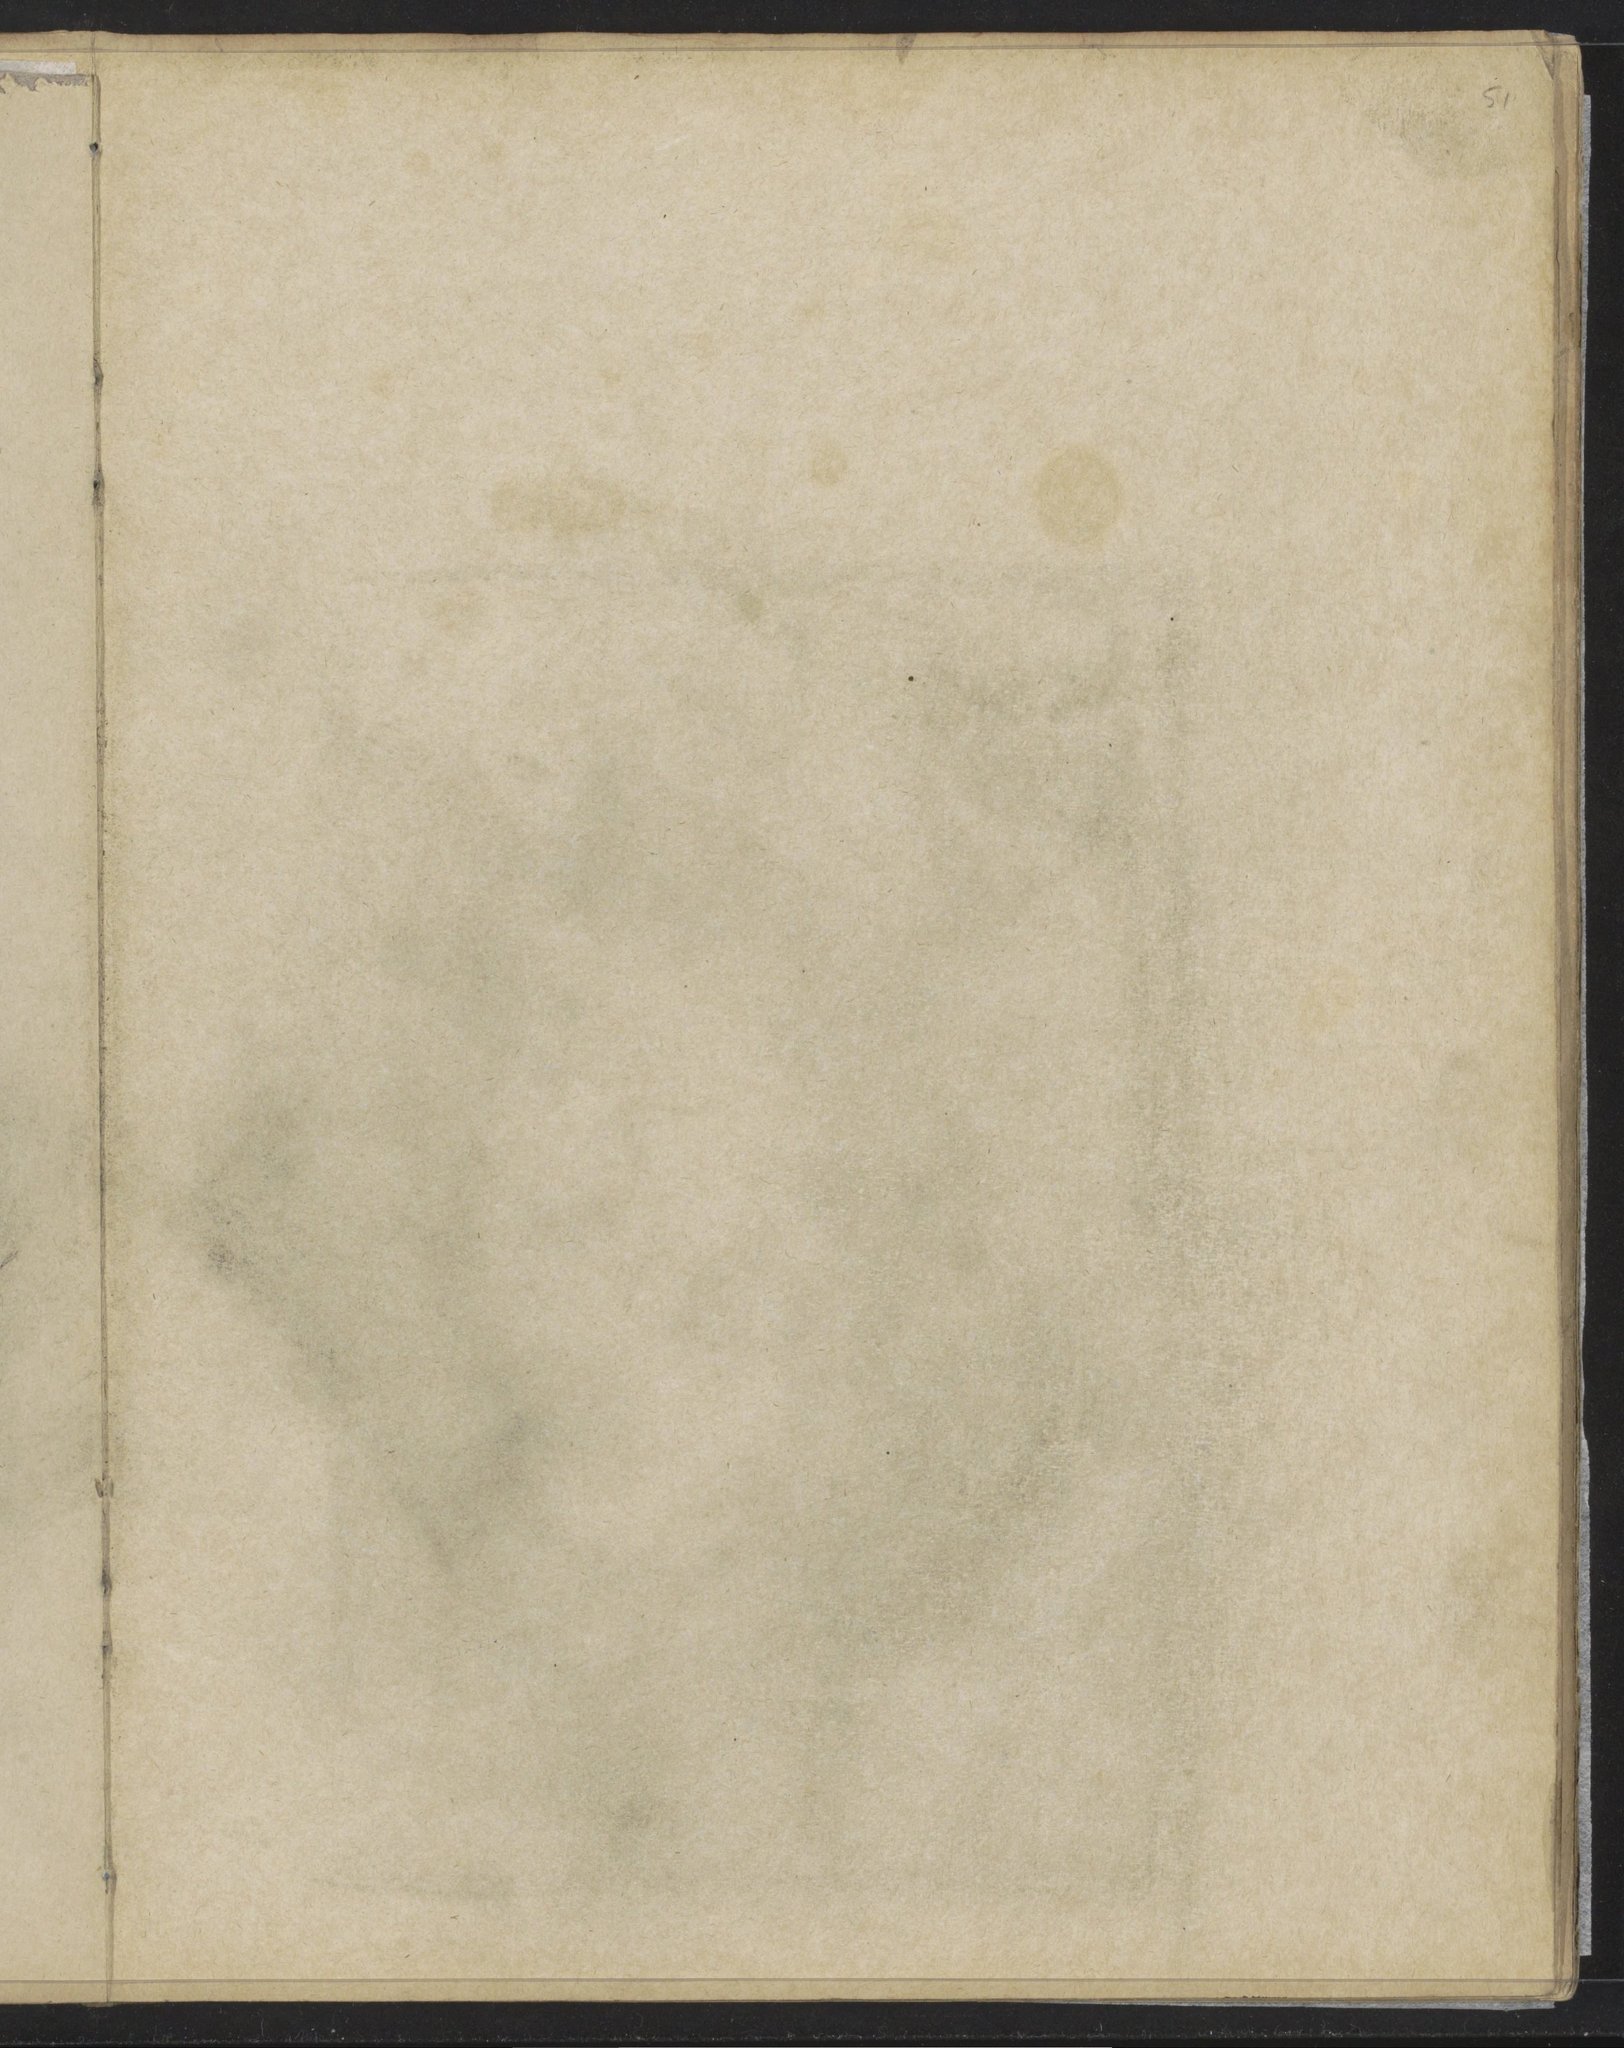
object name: sketchbook leaf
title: Abklatsch van de krijttekening op pagina 50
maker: willem witsen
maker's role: draughtsman, painter, print maker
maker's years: 1860-1923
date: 1886-1891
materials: paper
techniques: printmaking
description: Pagina 51 uit een schetsboek met 40 bladen.